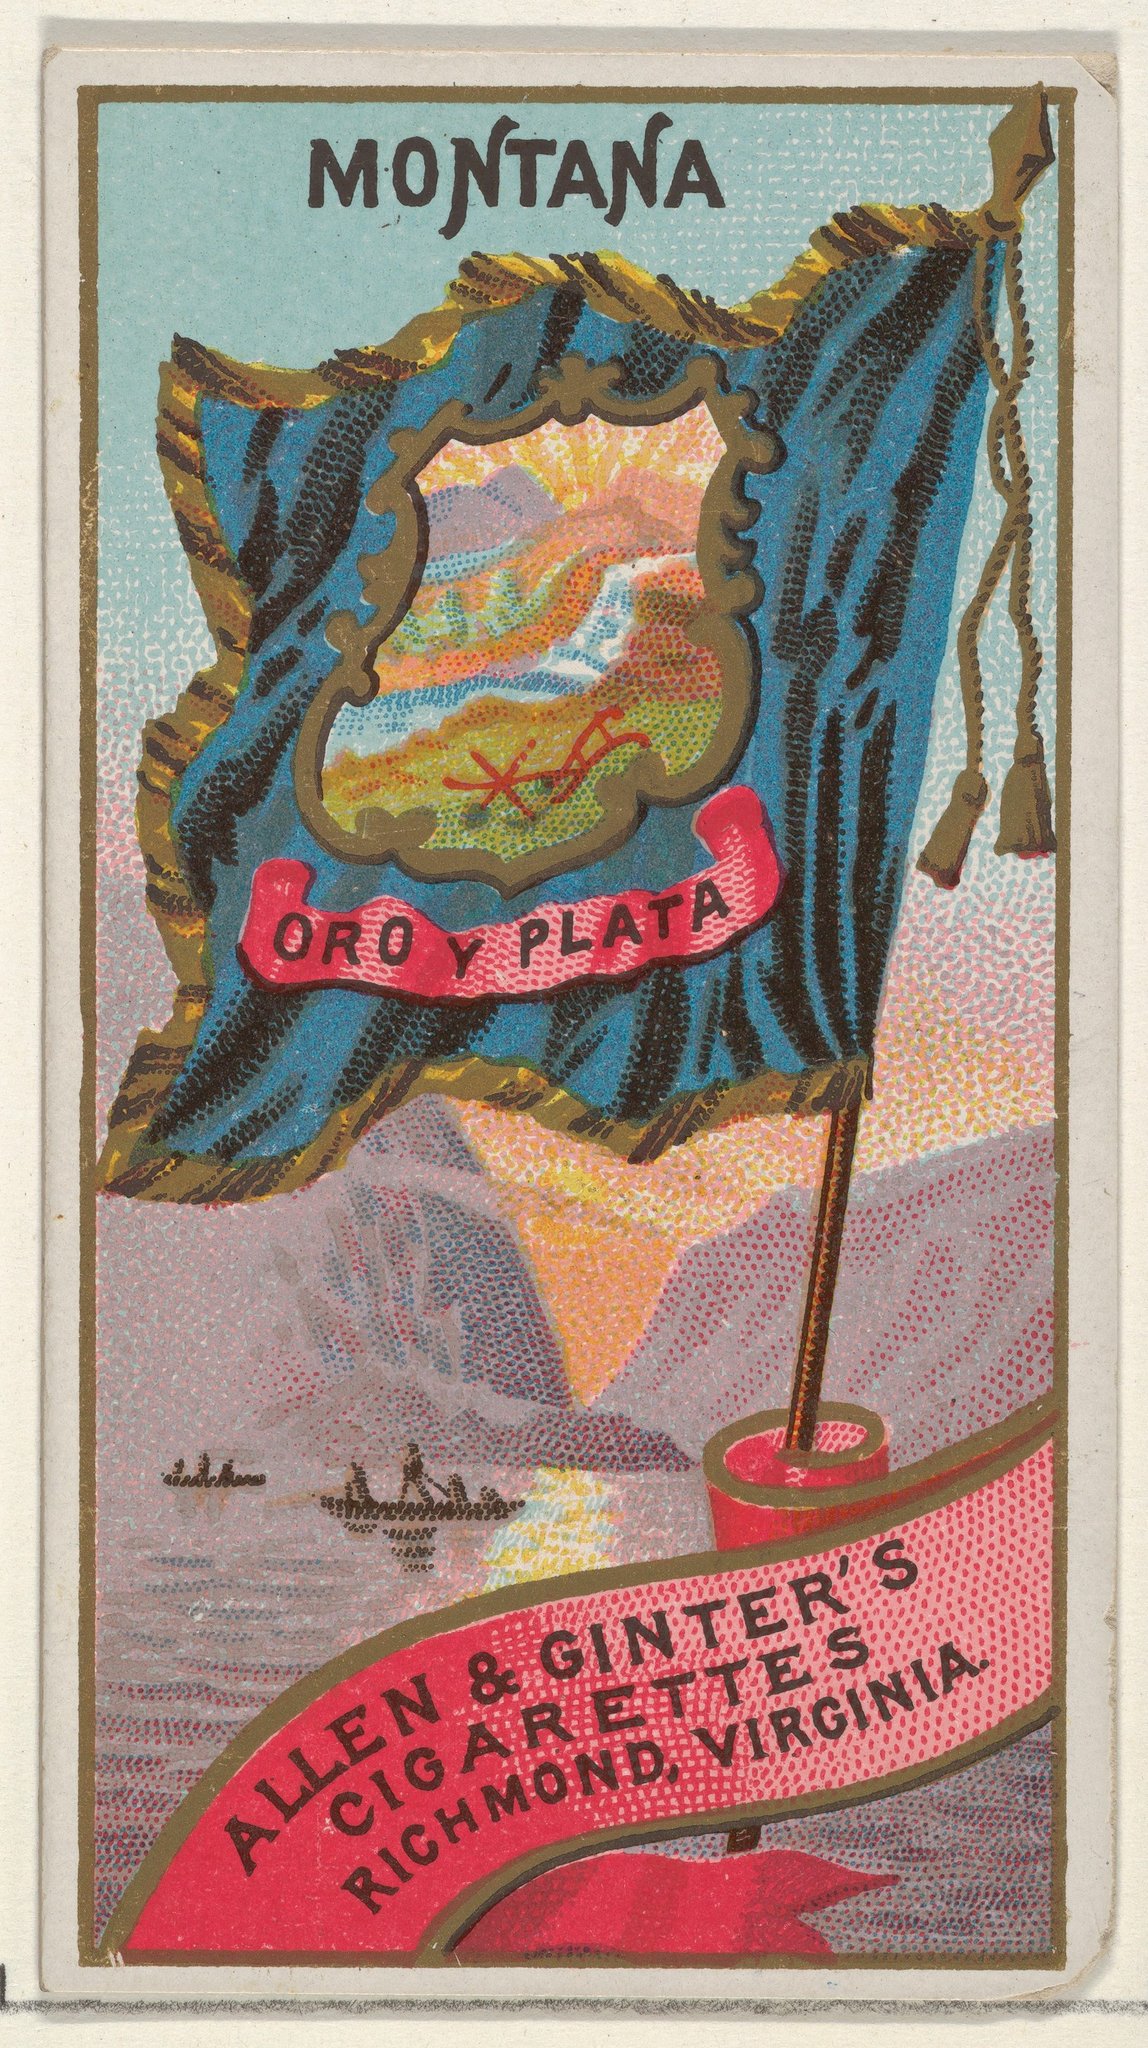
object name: print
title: Montana, from Flags of the States and Territories (N11) for Allen & Ginter Cigarettes Brands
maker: allen & ginter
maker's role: publisher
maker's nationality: american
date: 1888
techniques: color lithograph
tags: flags